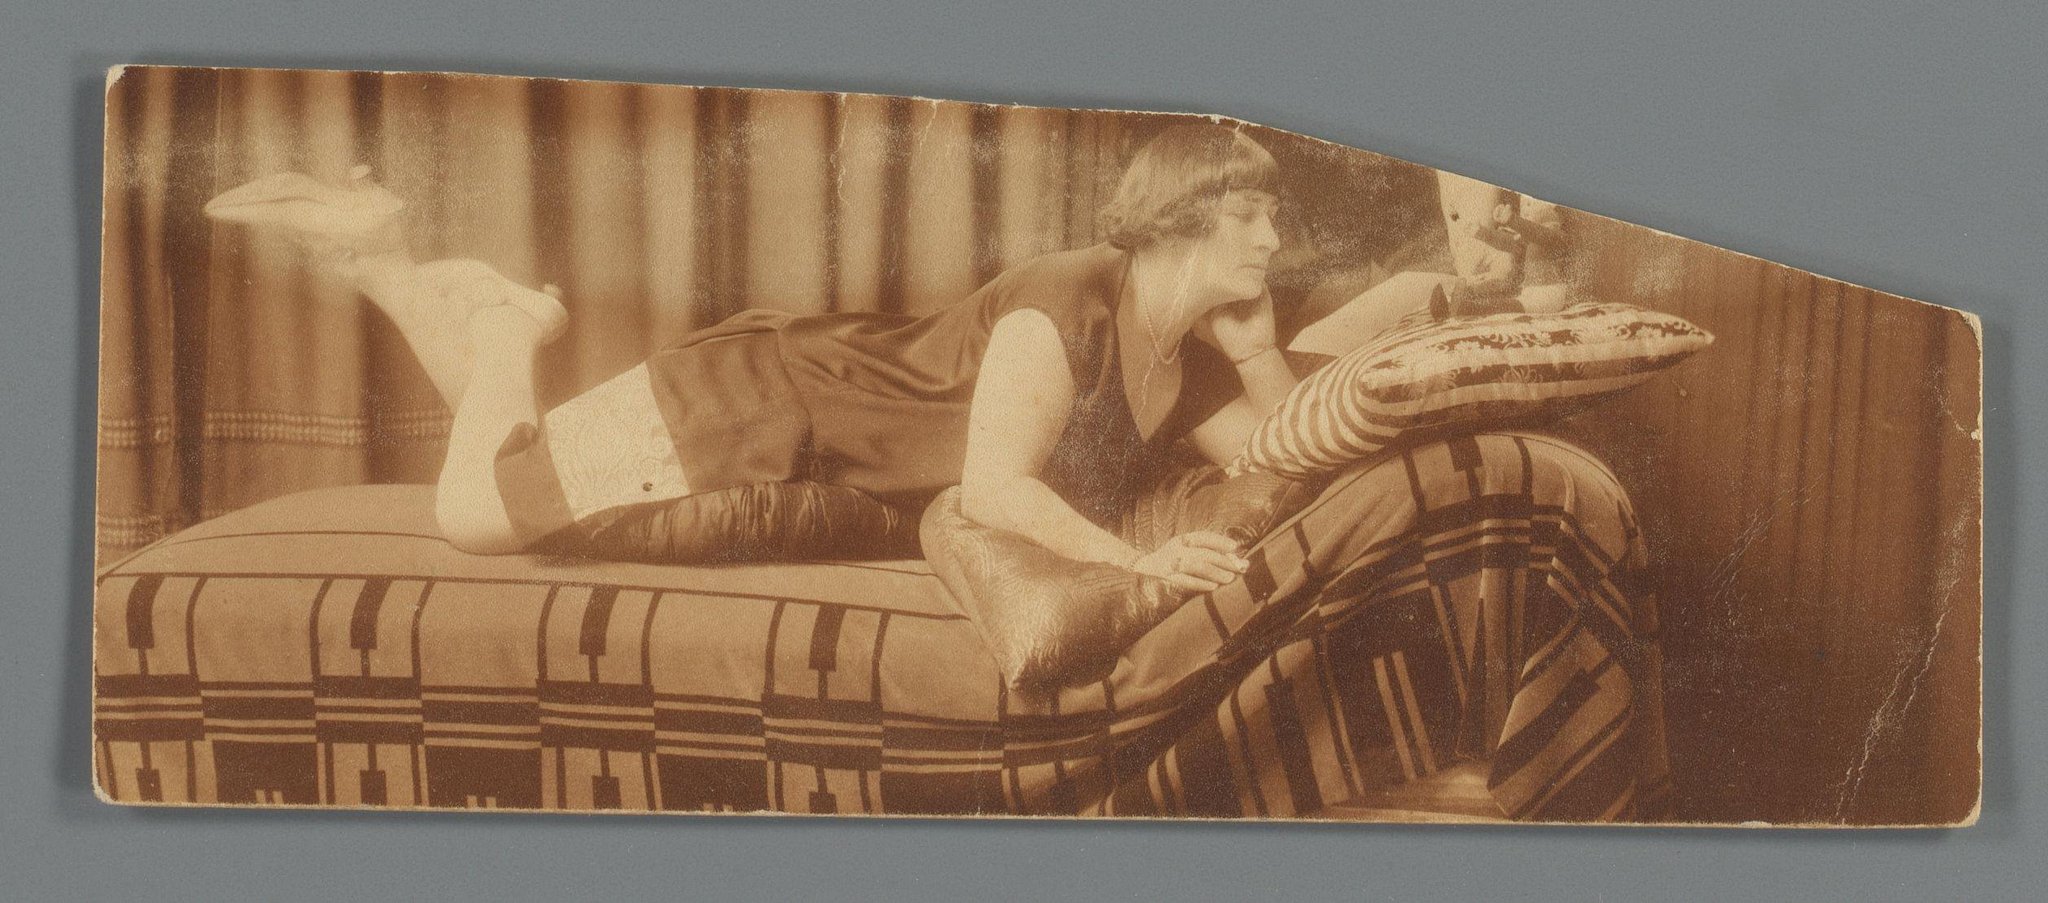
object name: photograph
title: Portret van Cato Merks, liggend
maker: wilhelm coenraad dettmeijer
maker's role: fotograaf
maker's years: 1892-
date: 1927-1934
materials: paper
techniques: gelatin silver print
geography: rotterdam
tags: historical persons - bb - woman, portrait of cabaret-artiste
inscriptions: inscription: ‘Cato Merks’, stamp: ‘Fotoatelier/ Singel 219/ rdam,’